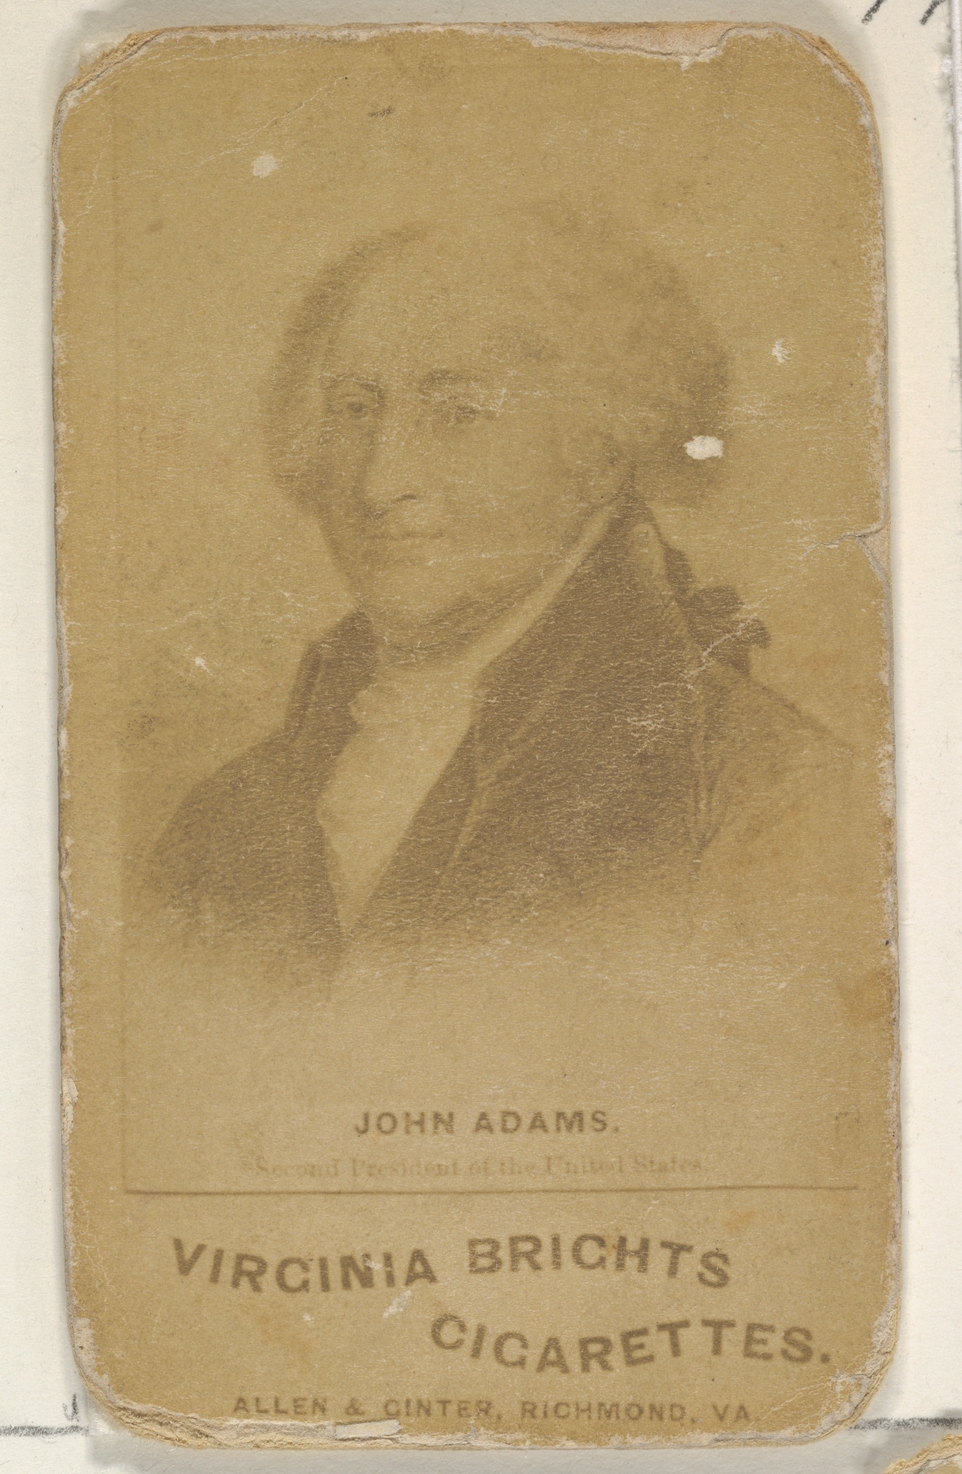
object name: photograph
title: John Adams, from the Presidents of the United States series (N51) for Virginia Brights Cigarettes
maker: allen & ginter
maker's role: publisher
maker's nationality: american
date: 1885-1889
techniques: albumen silver print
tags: men,portraits